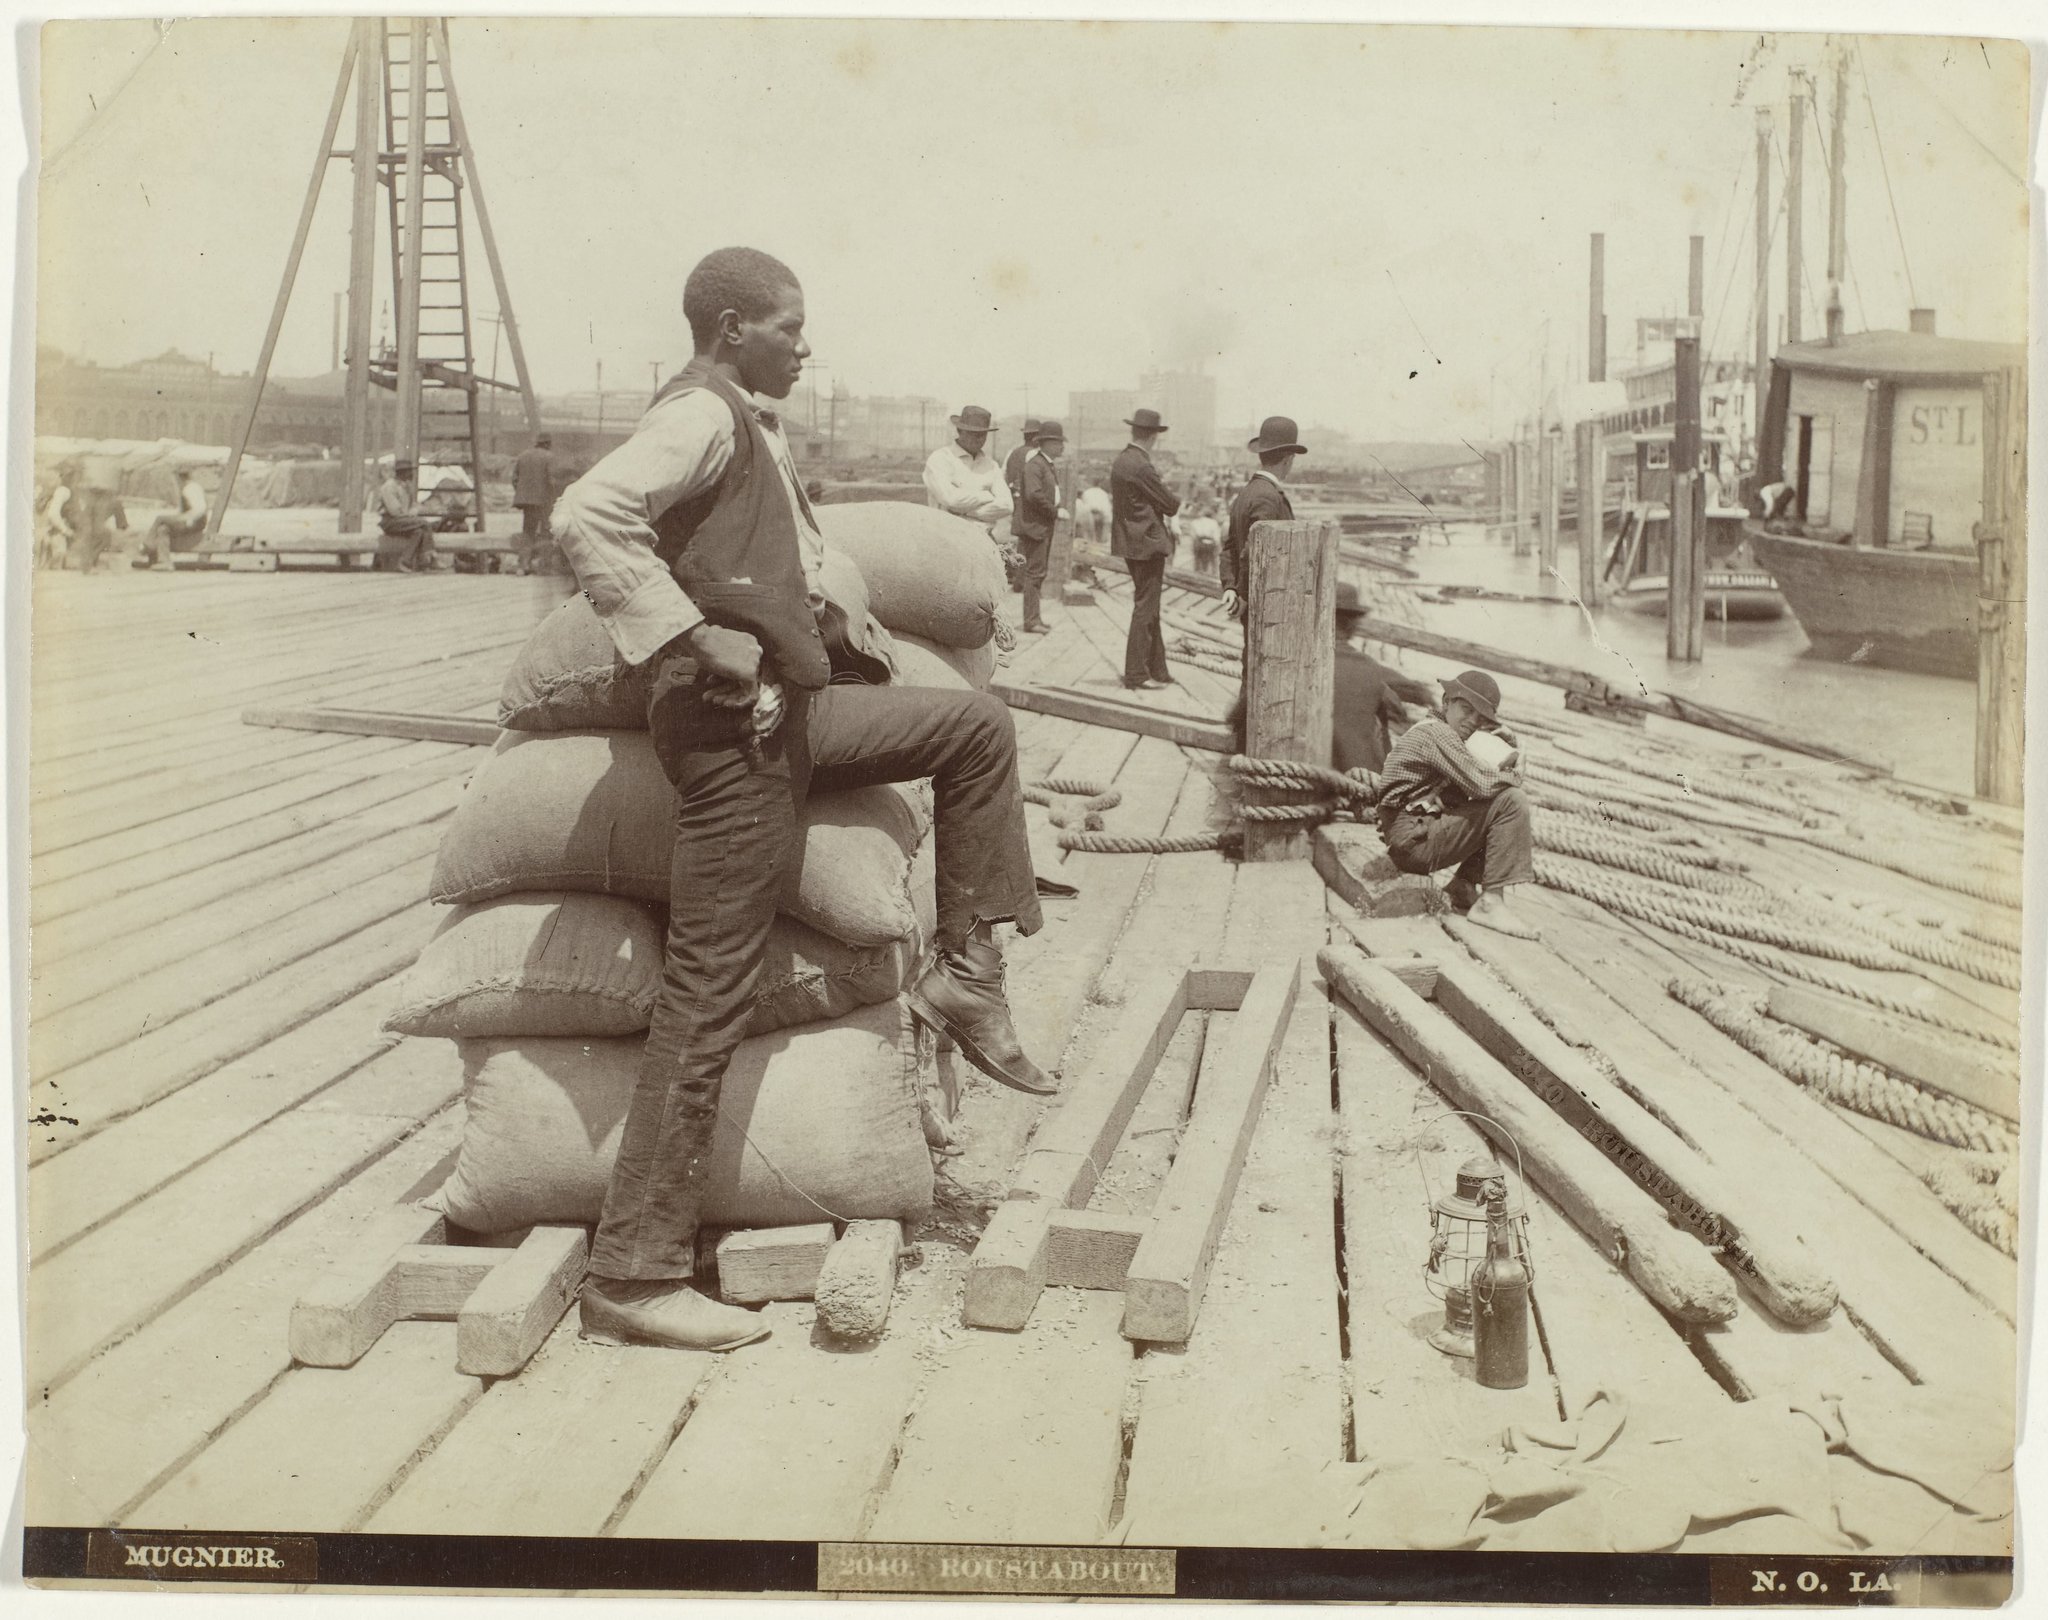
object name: photograph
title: Roustabout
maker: george françois mugnier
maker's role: fotograaf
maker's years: 1855-1938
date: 1880-1888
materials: cardboard, paper, photographic support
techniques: albumen print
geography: new orleans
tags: harbour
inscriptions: negative number: ‘2040’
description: Onderdeel van Fotoalbum van een reis door de Verenigde Staten, Honolulu, Nederlands-Indië, Aden, Zanzibar en Zuidelijk Afrika.